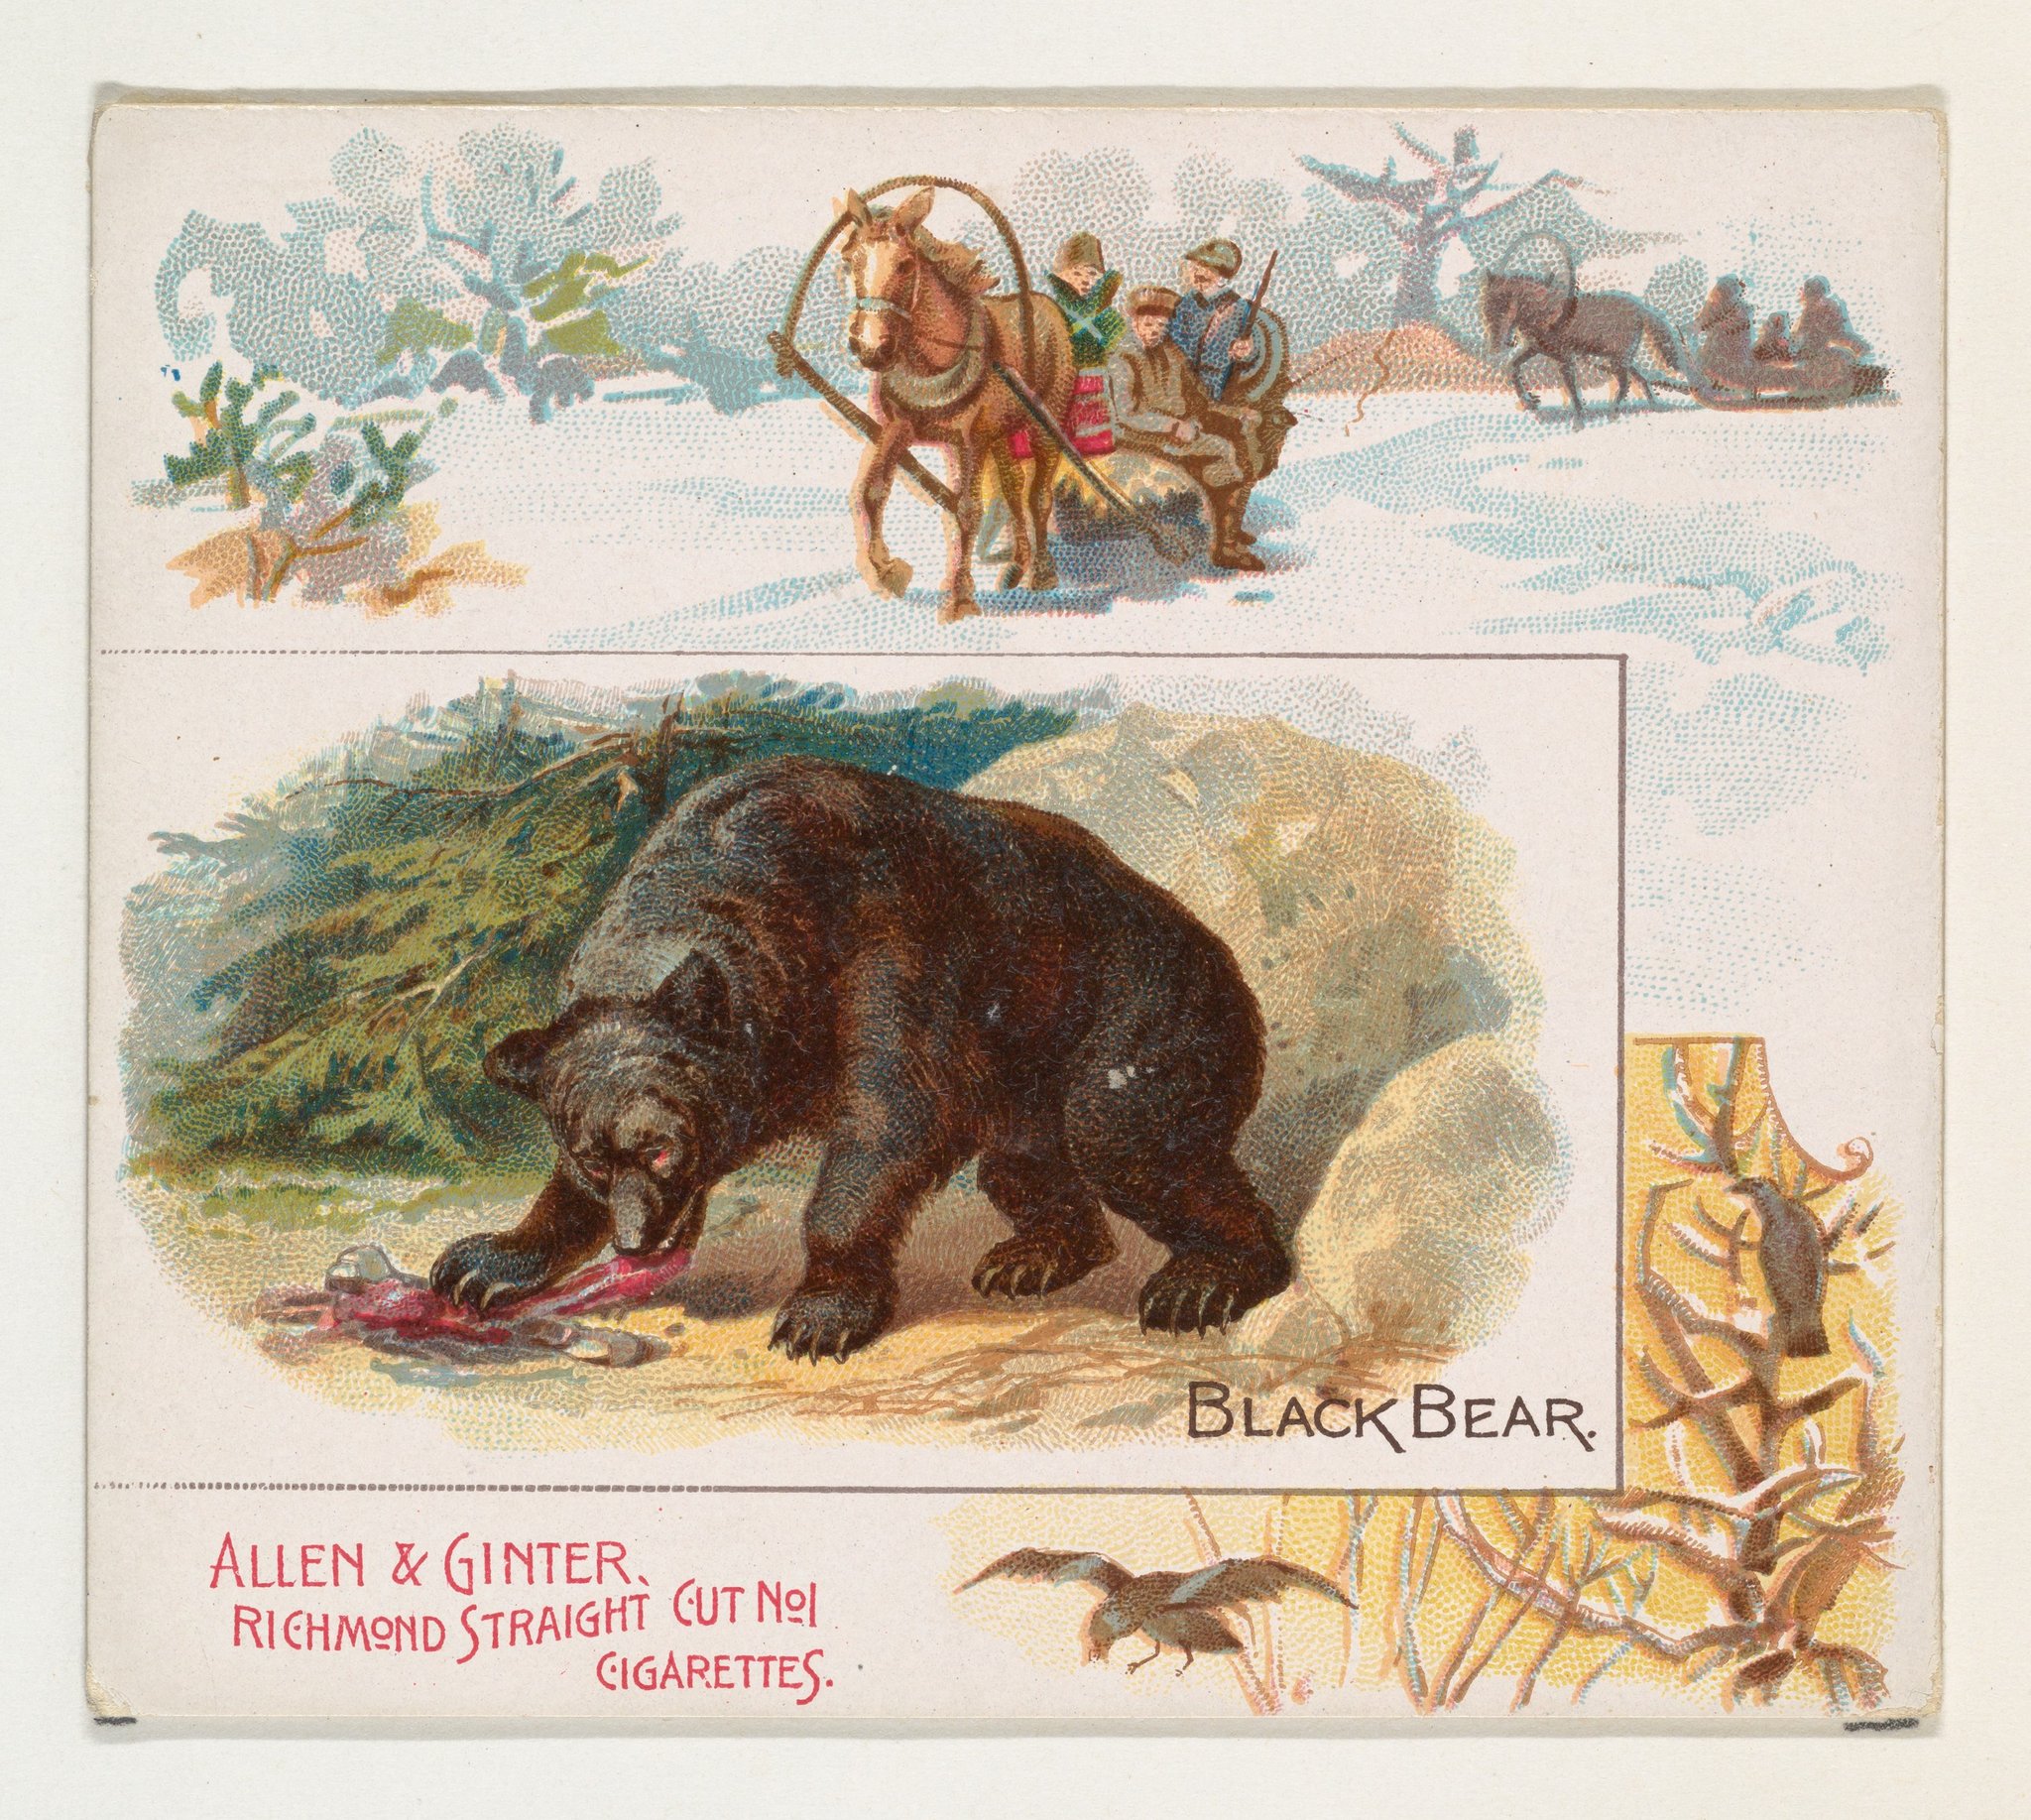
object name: print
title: Black Bear, from Quadrupeds series (N41) for Allen & Ginter Cigarettes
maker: allen & ginter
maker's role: publisher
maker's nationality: american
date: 1890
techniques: color lithograph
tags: bears